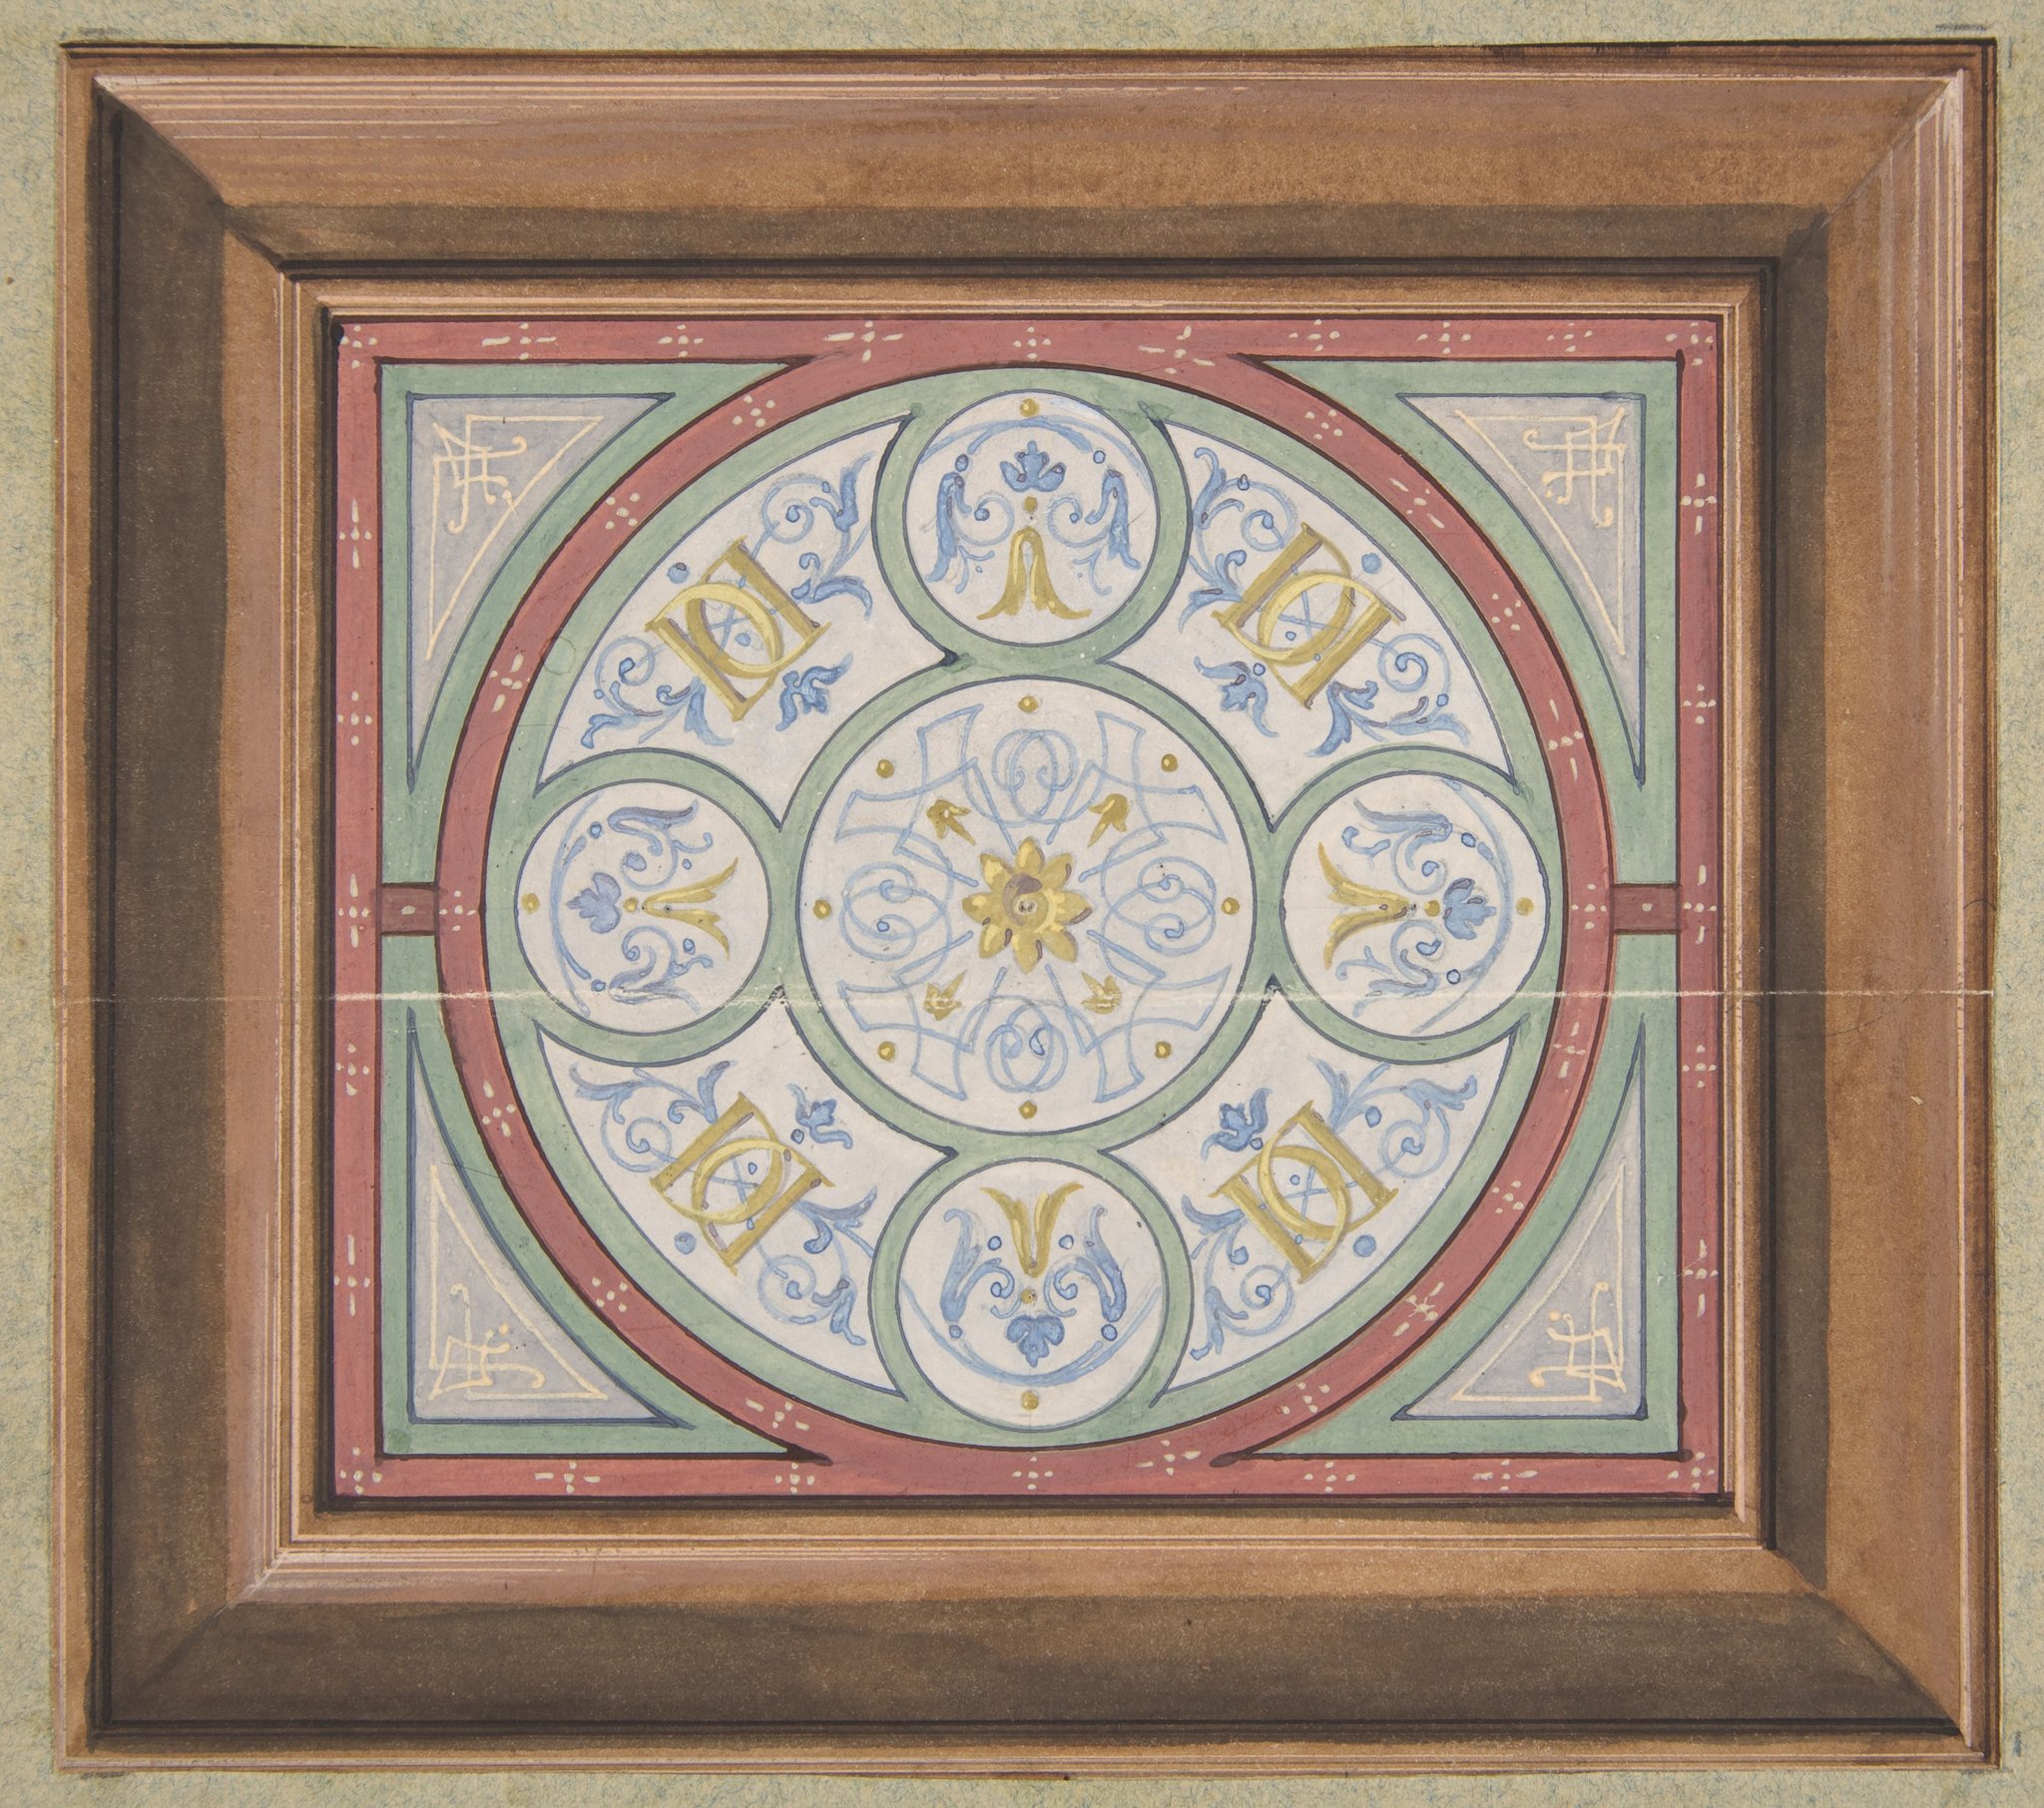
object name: drawing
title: Design for painted decoration of a ceiling incorporating interwined initials: DD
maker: jules-edmond-charles lachaise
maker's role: artist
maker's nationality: french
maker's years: 1897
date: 1851-1900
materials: ink, watercolor, paper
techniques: pen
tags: ceilings